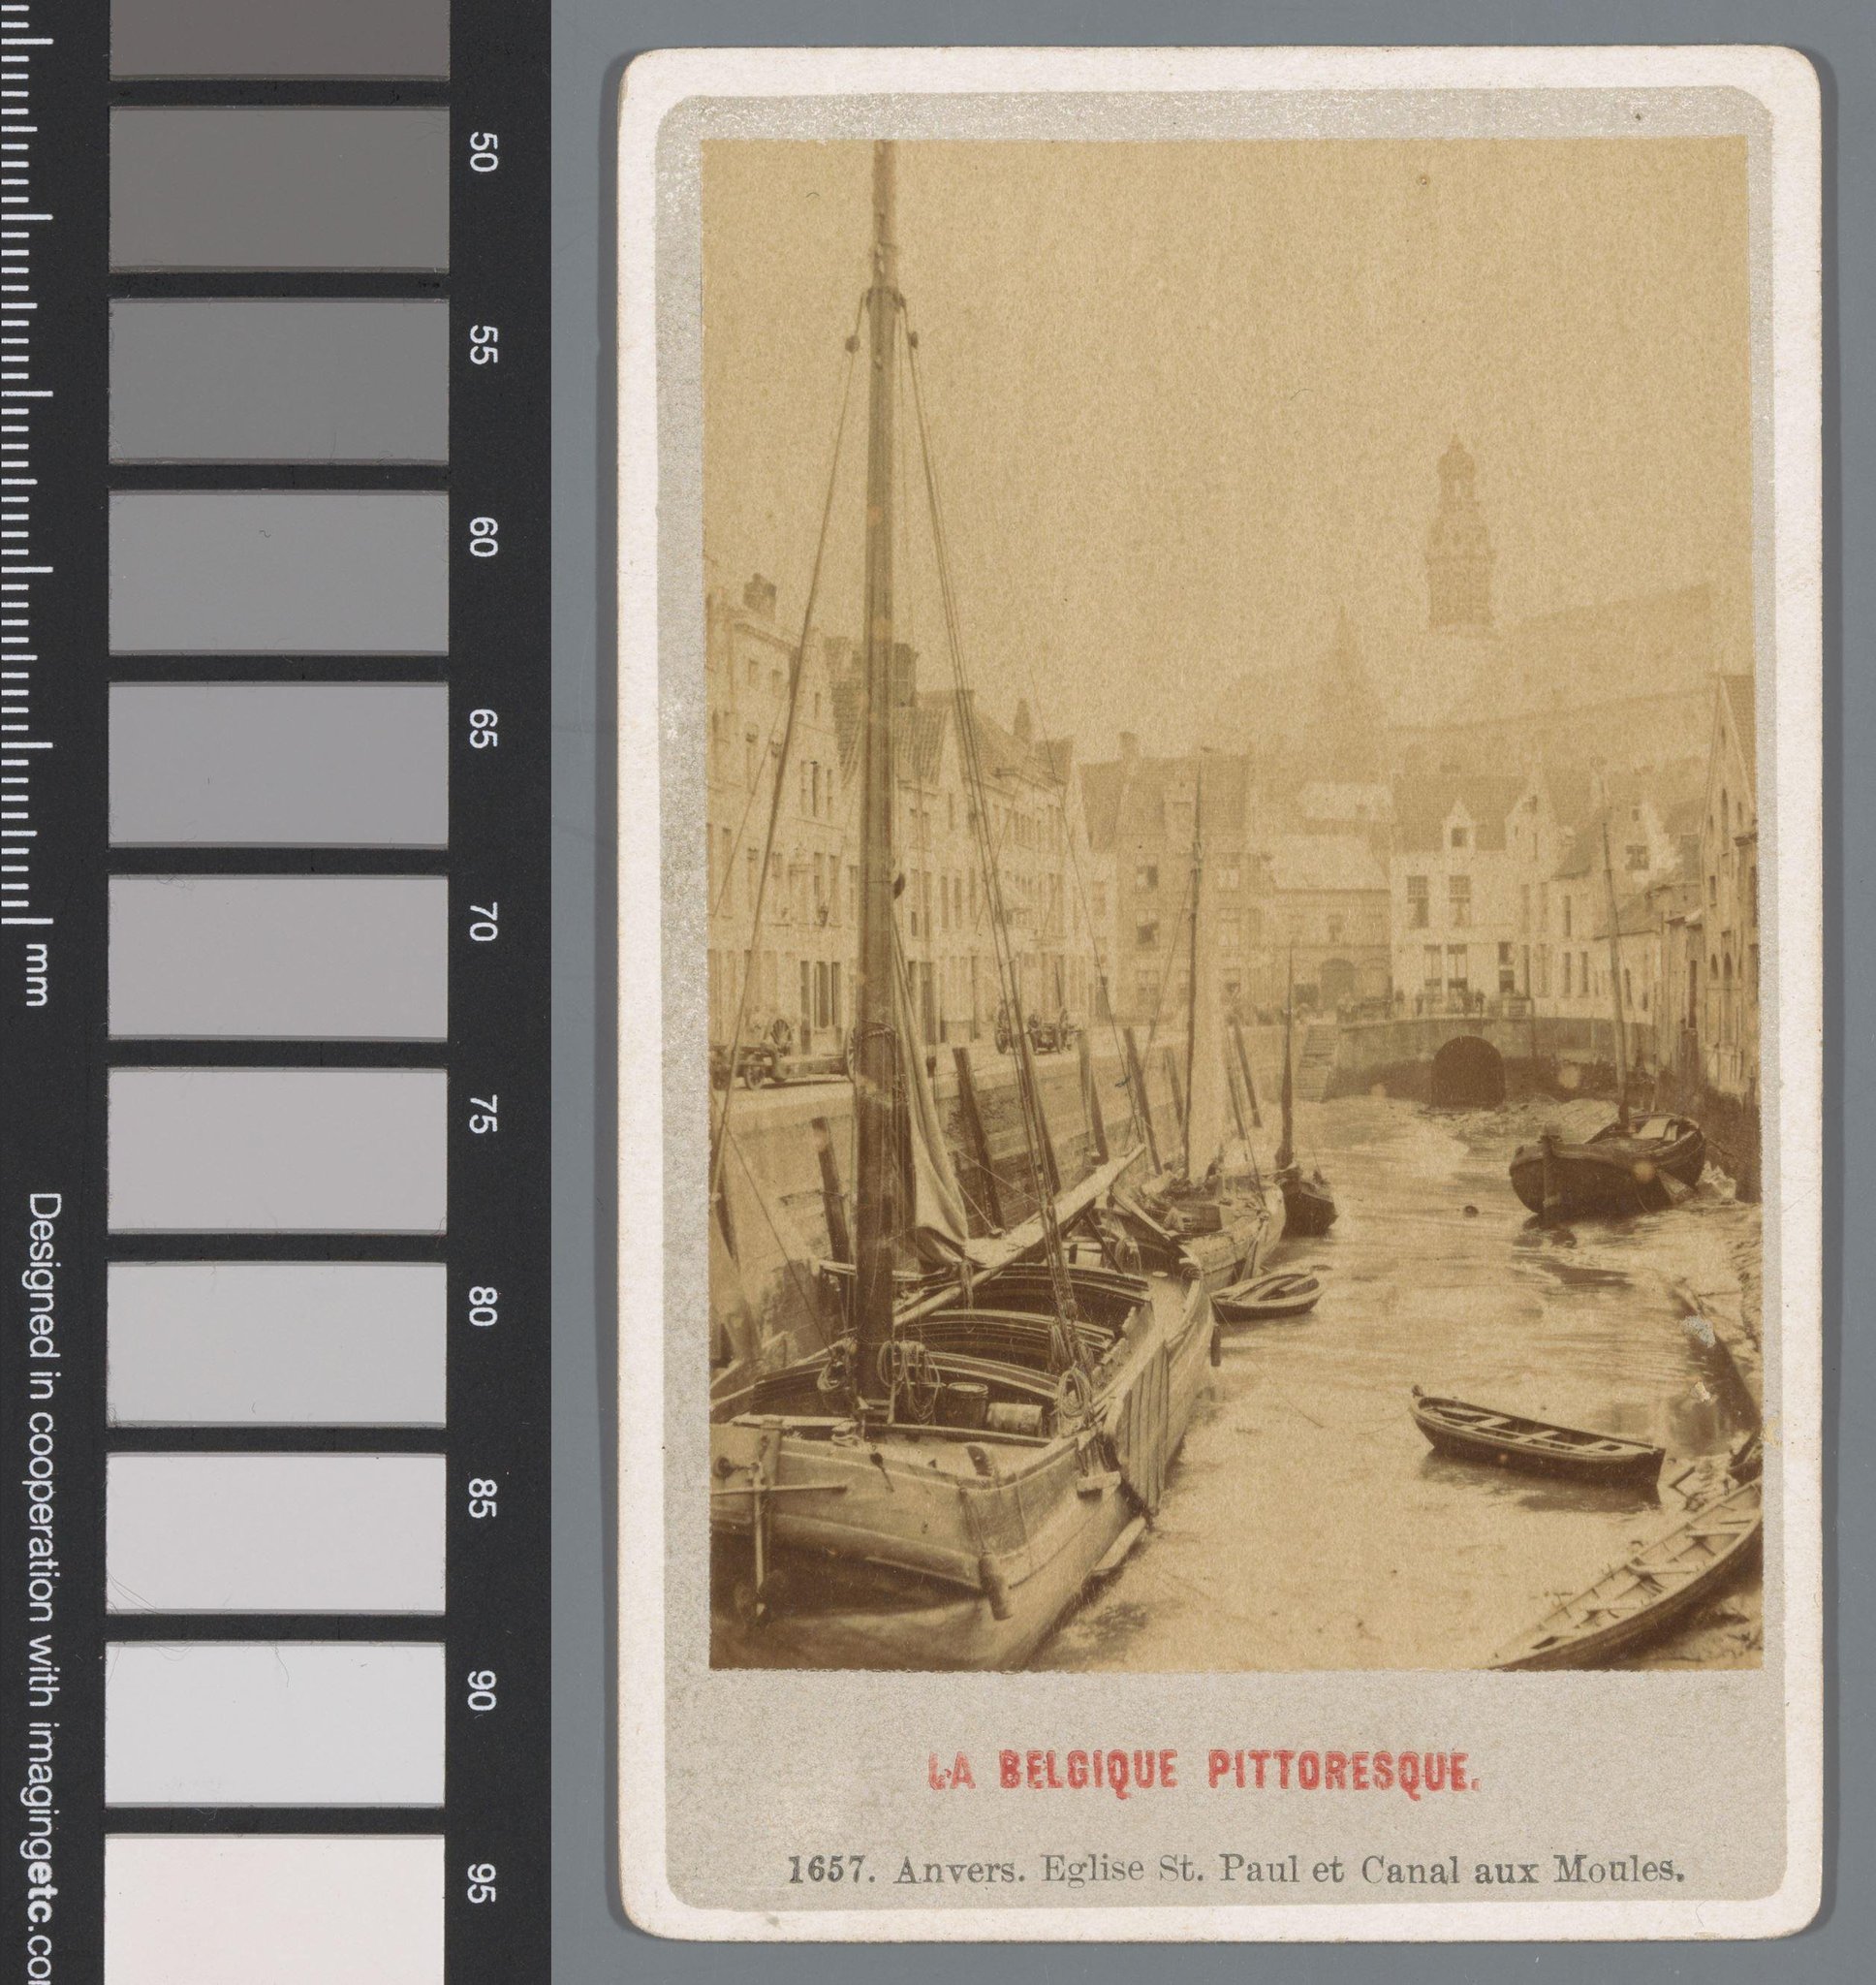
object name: carte de visite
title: Anvers. Eglise St. Paul et Canal aux Moules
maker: Anonymous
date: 1866-1906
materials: cardboard, paper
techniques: albumen print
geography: antwerp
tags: canals, waters (in city), antwerp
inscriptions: inscription: ‘Ancienne maison F. Tessaro/ G. Zazzarini & Cie, Successeurs/ 37, Marché aux Souliers/ Anvers’, number: ‘1657.’